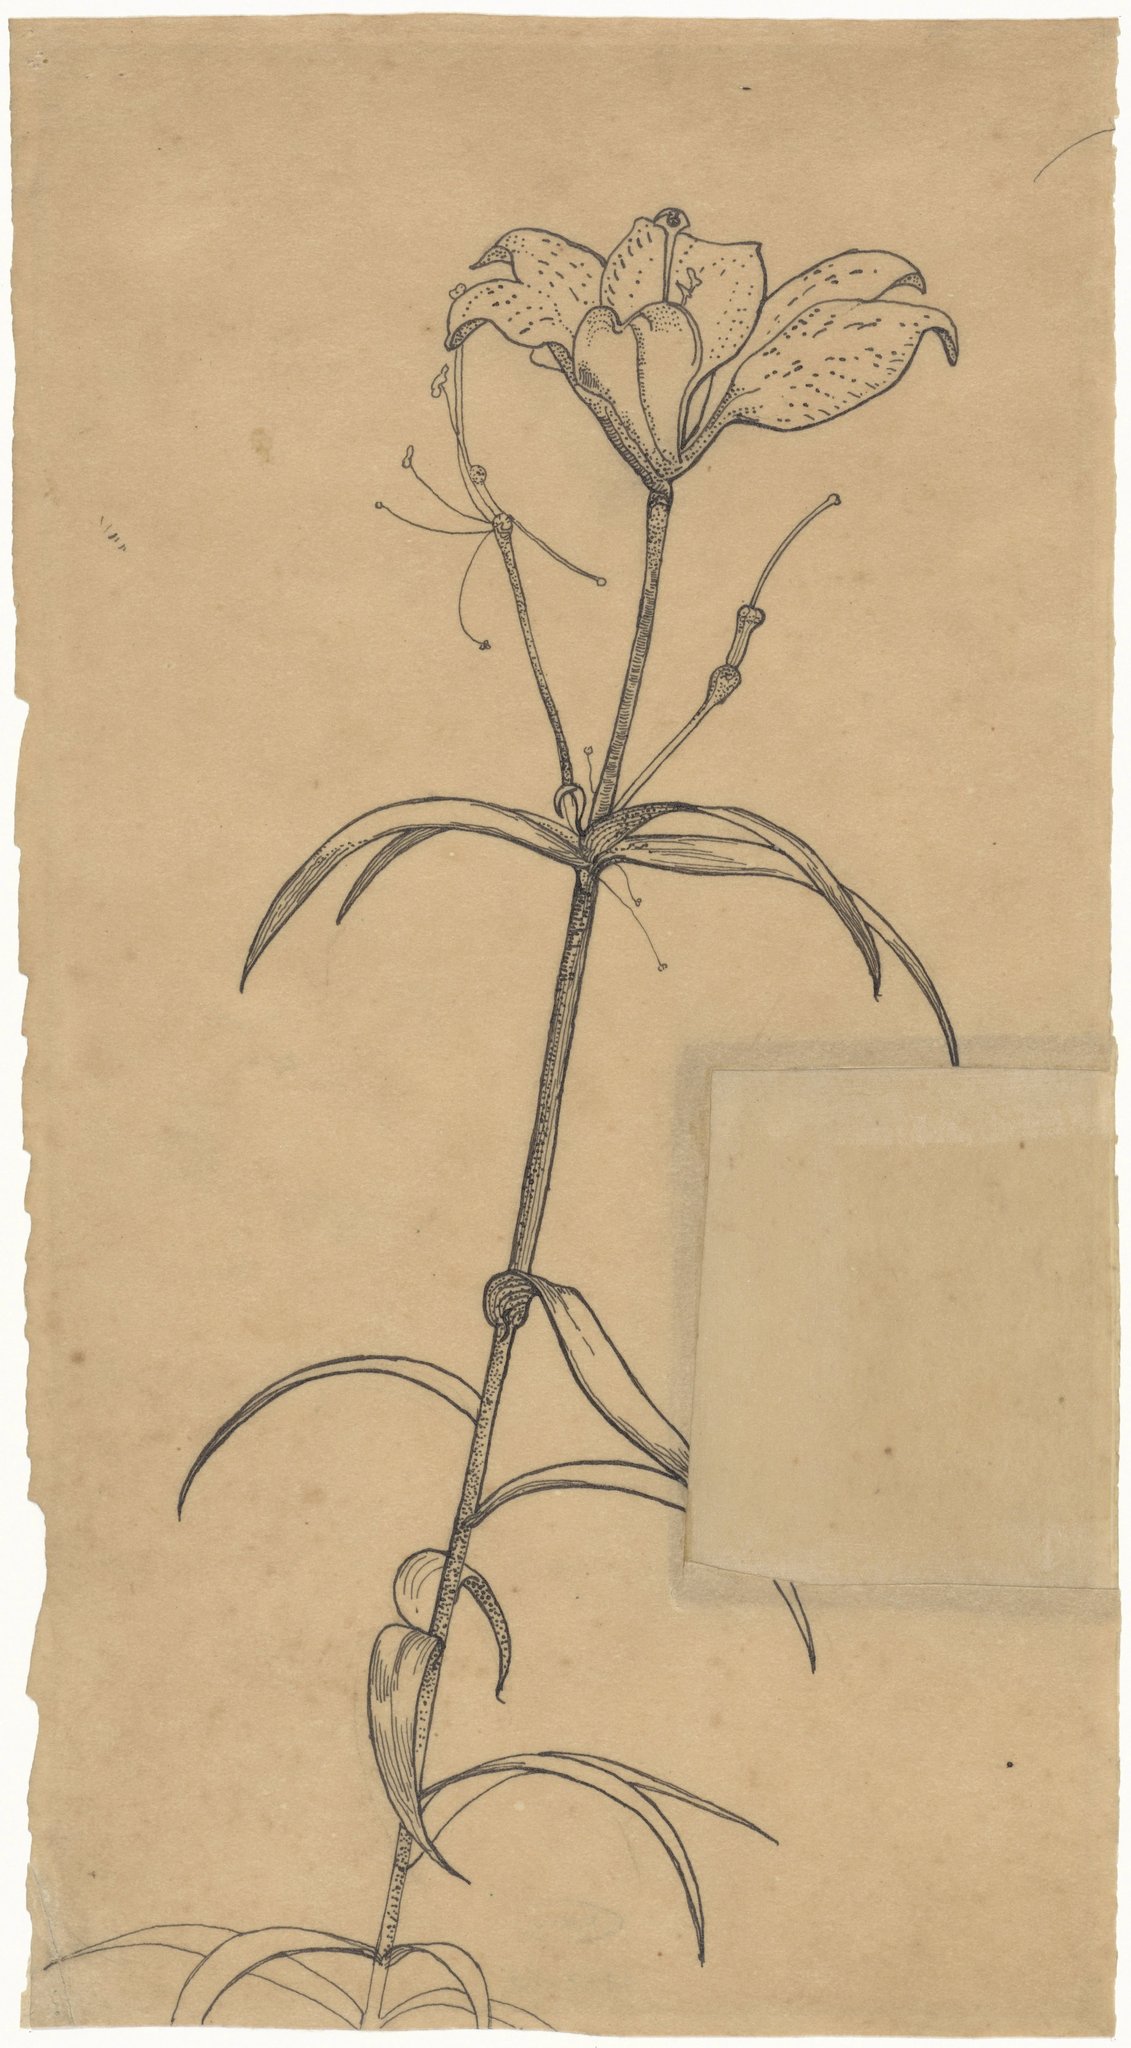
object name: drawing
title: Tijgerlelie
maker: richard nicolaüs roland holst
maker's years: 1868-1938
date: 1878-1938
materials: ink, paper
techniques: pen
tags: flowers: tiger-lily